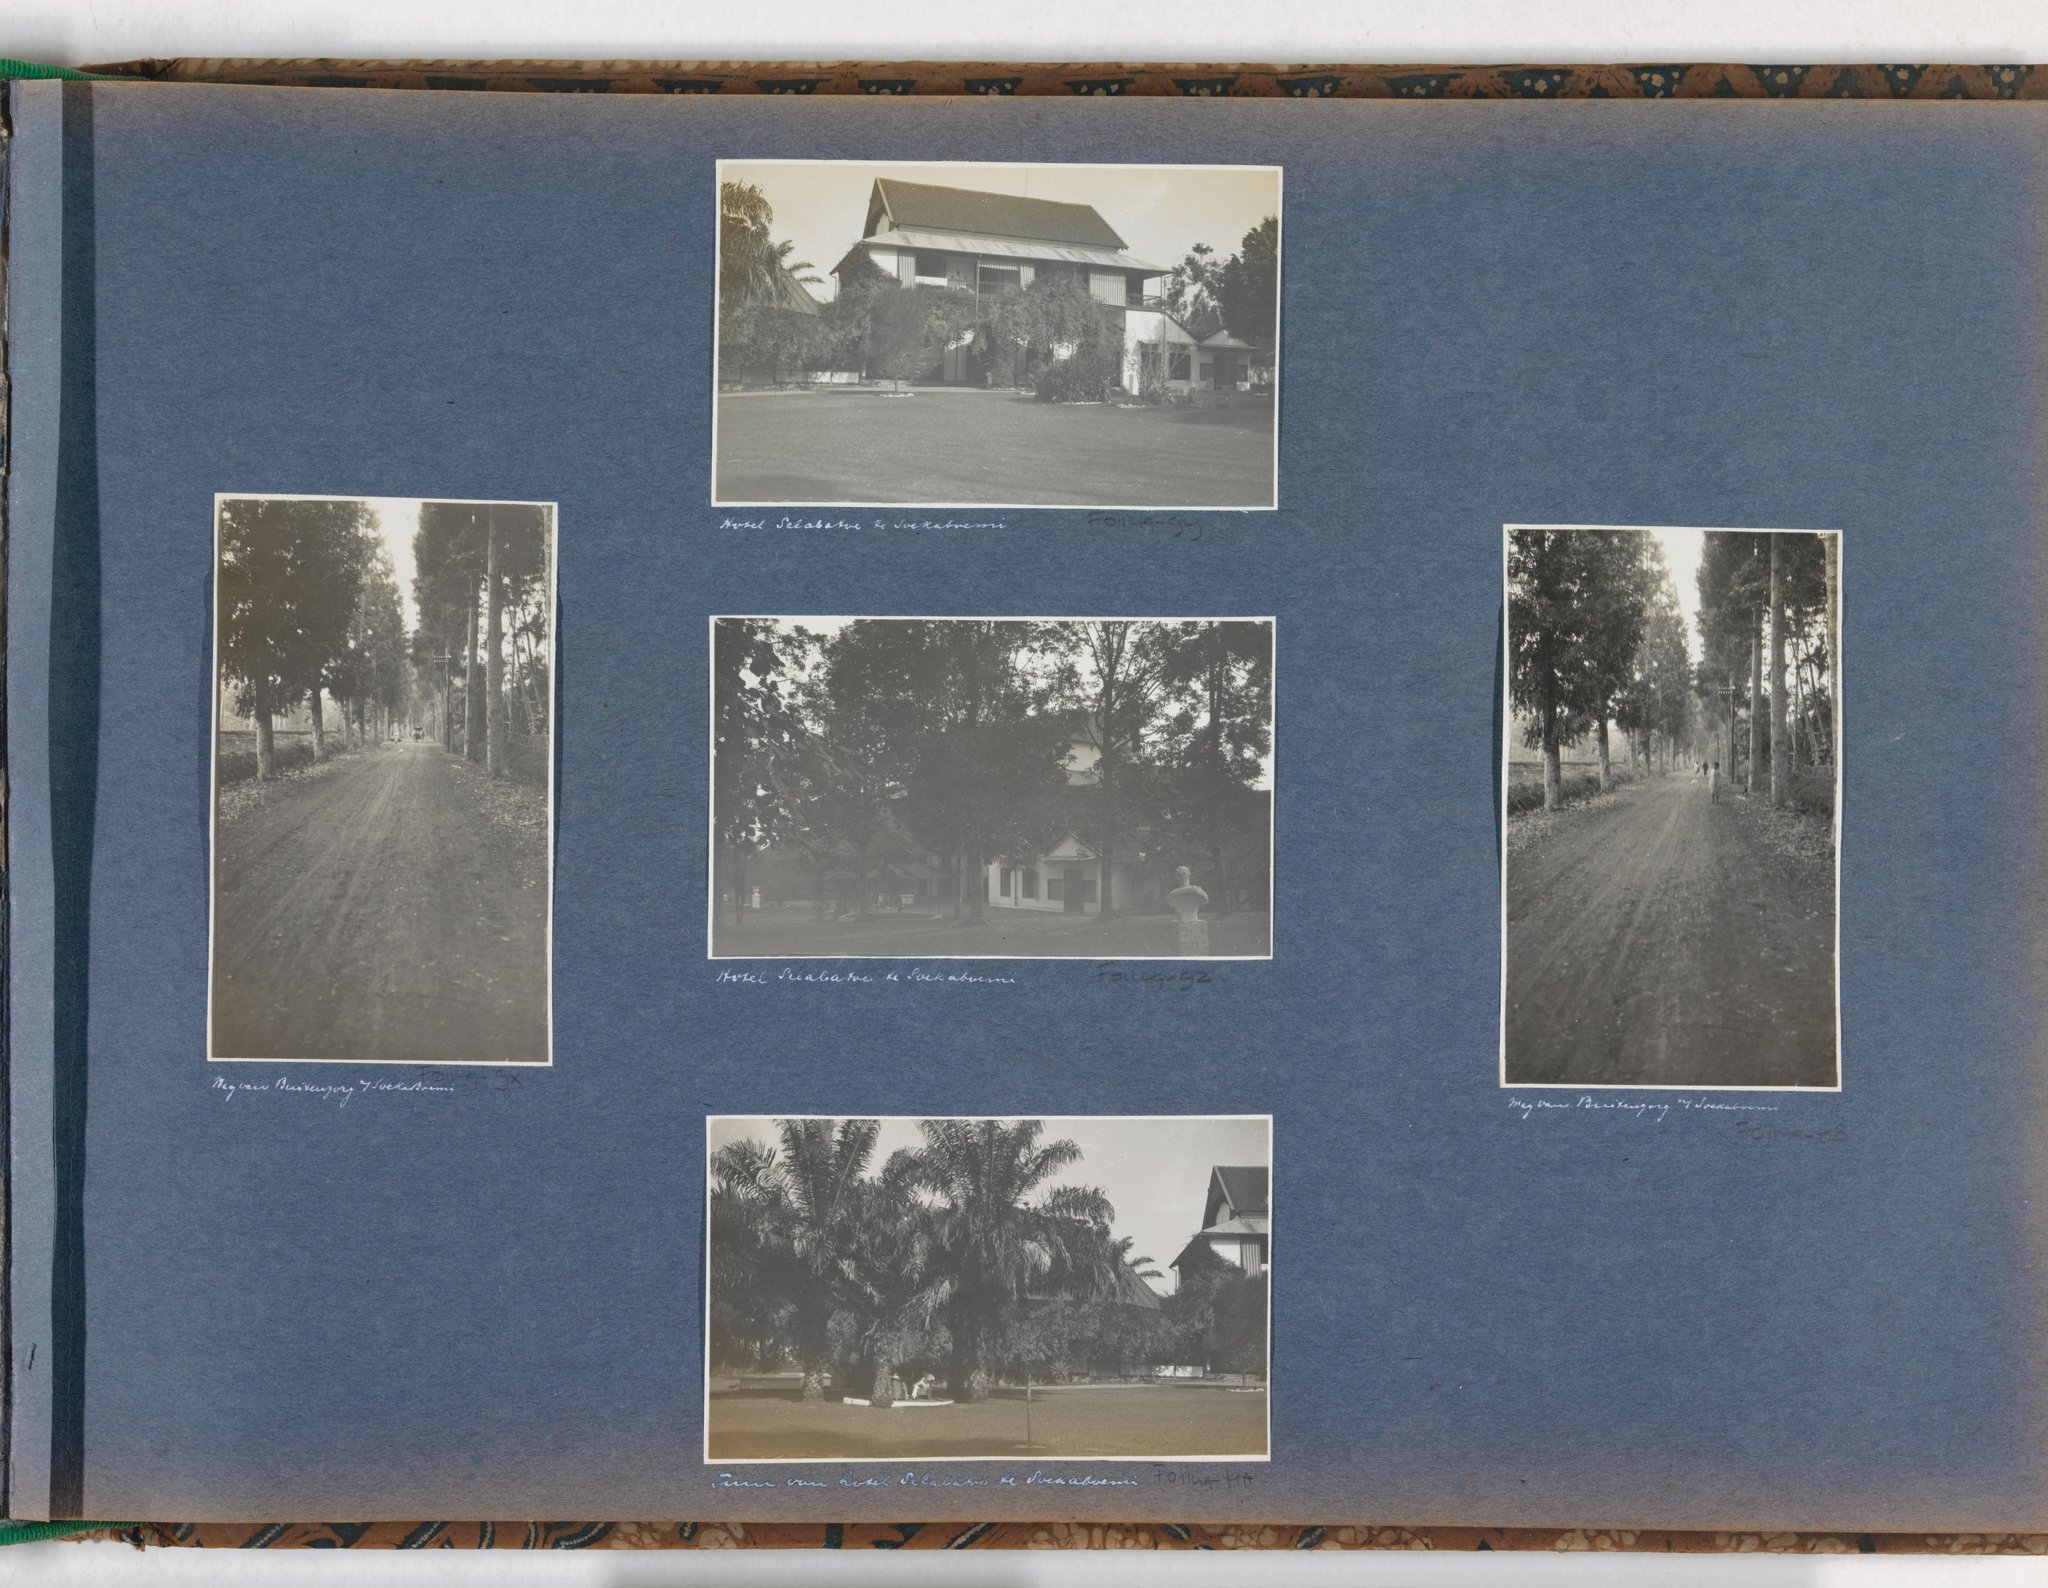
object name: photograph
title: Weg van Buitenzorg naar Soekaboemi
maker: Anonymous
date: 1900-1920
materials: paper, photographic support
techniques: gelatin silver print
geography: java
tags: forest path or lane, java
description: Onderdeel van reisalbum met foto's van bedrijvigheid en bezienswaardigheden op Sumatra en Java en van de reis naar en van Nederlands-Indië.